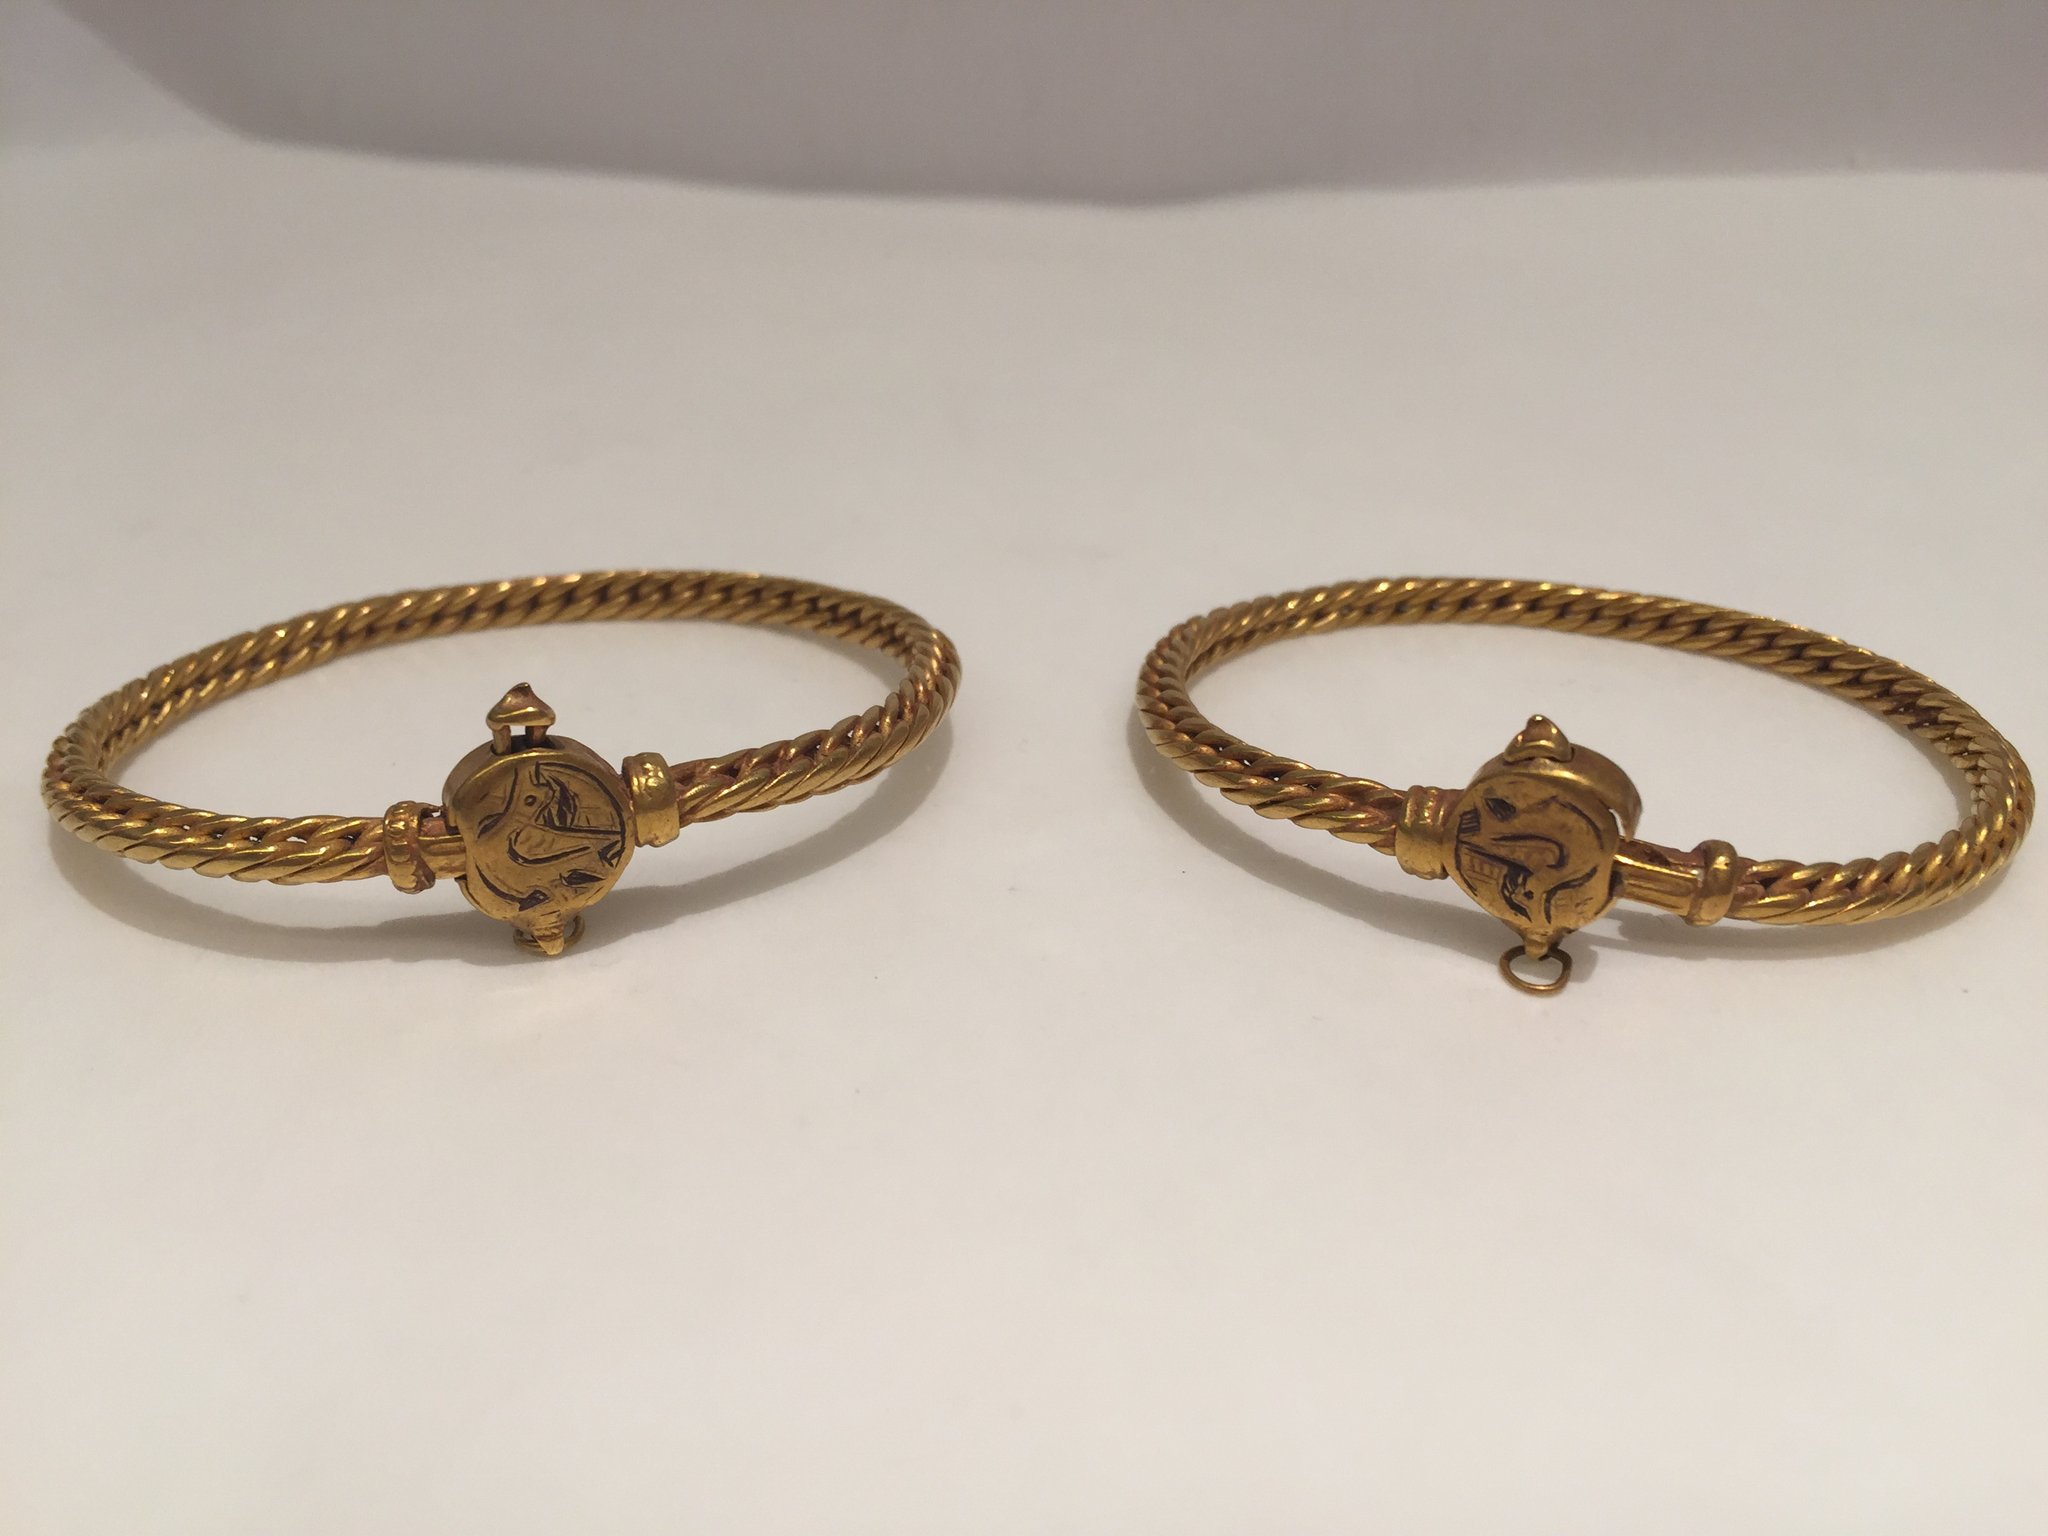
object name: bracelet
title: Bracelet, One of a Pair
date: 1001-1300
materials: gold, metal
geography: iran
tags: birds